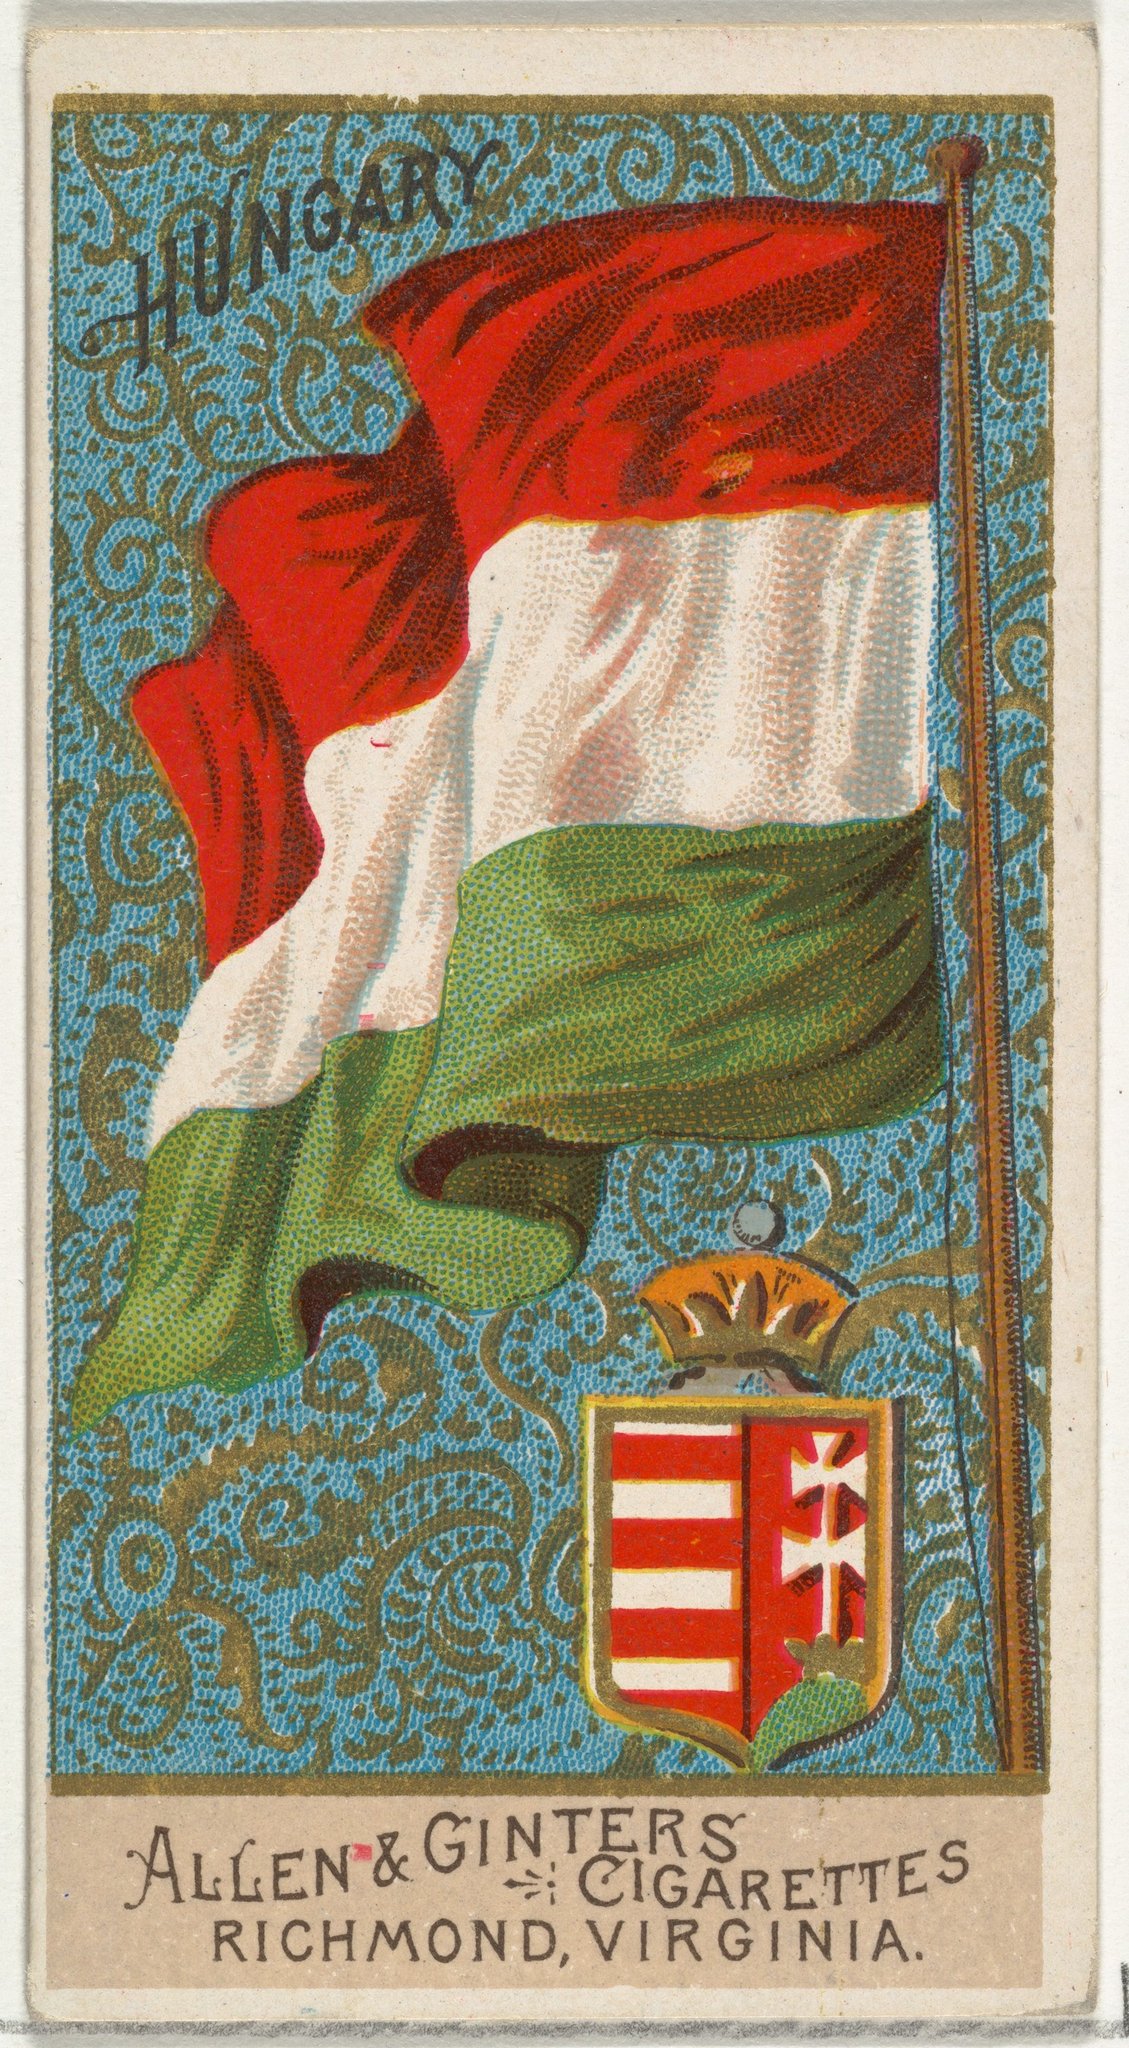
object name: print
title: Hungary, from Flags of All Nations, Series 2 (N10) for Allen & Ginter Cigarettes Brands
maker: allen & ginter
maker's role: publisher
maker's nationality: american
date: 1890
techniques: color lithograph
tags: coat of arms,flags